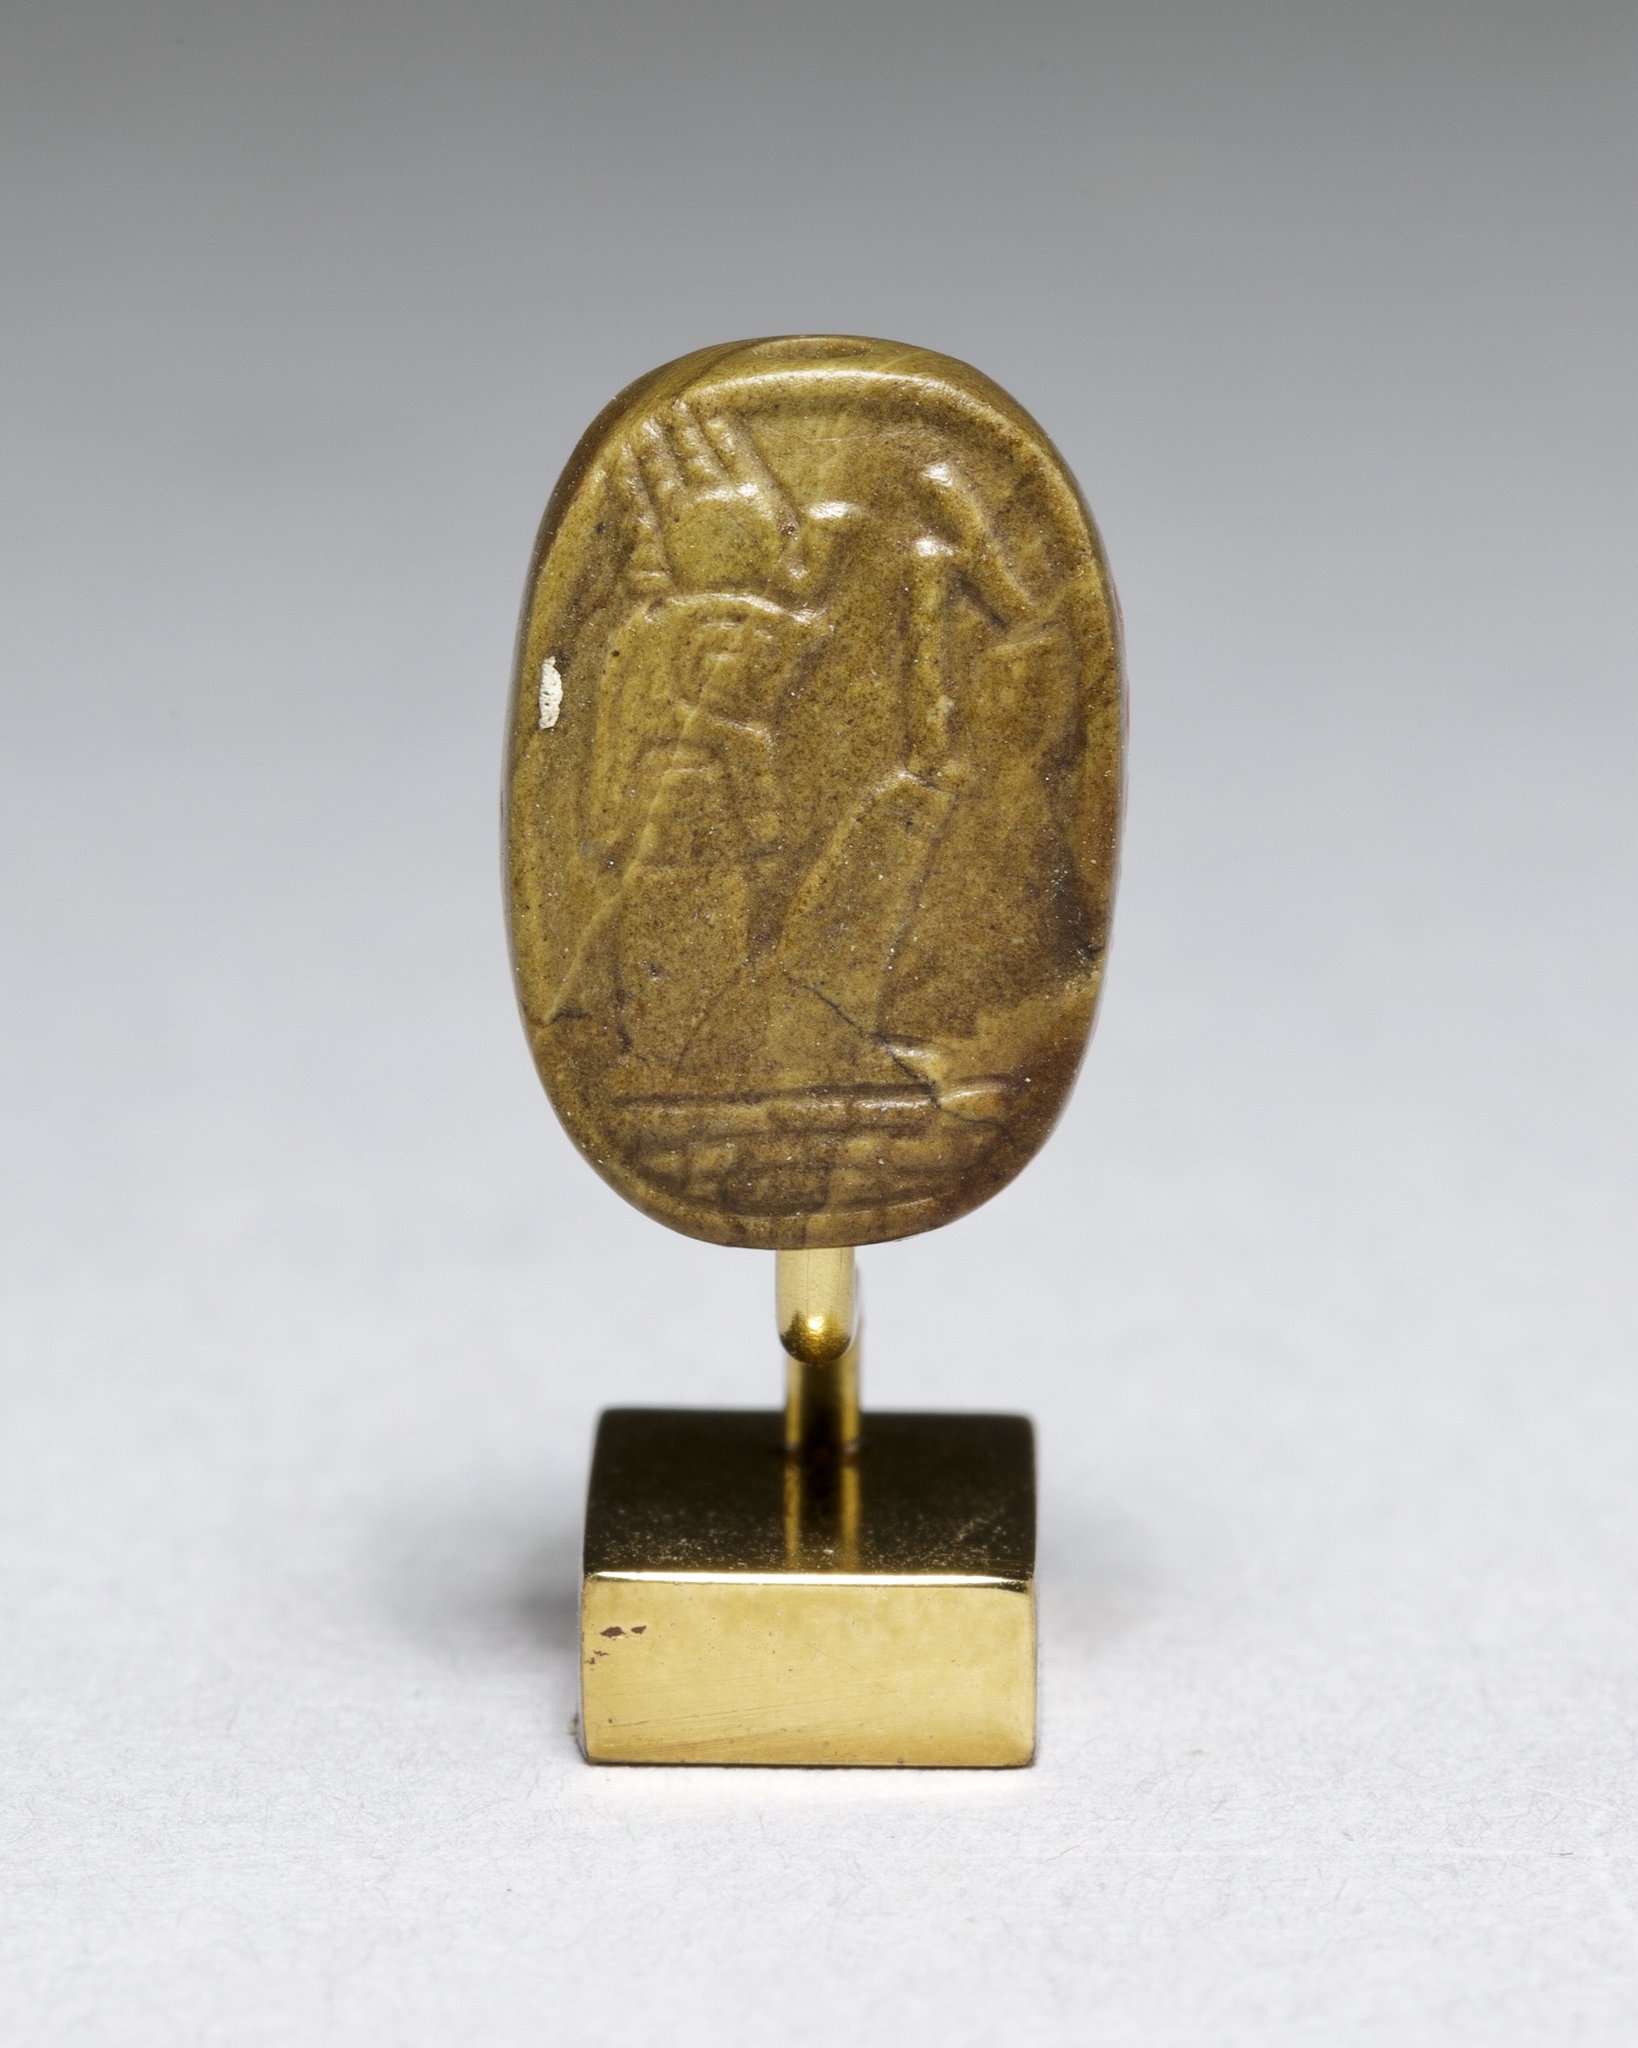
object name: scaraboid, re harakhty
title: Scaraboid, squatting Re-Harakhty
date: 664-332 BCE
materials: jasper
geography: egypt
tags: hieroglyphs